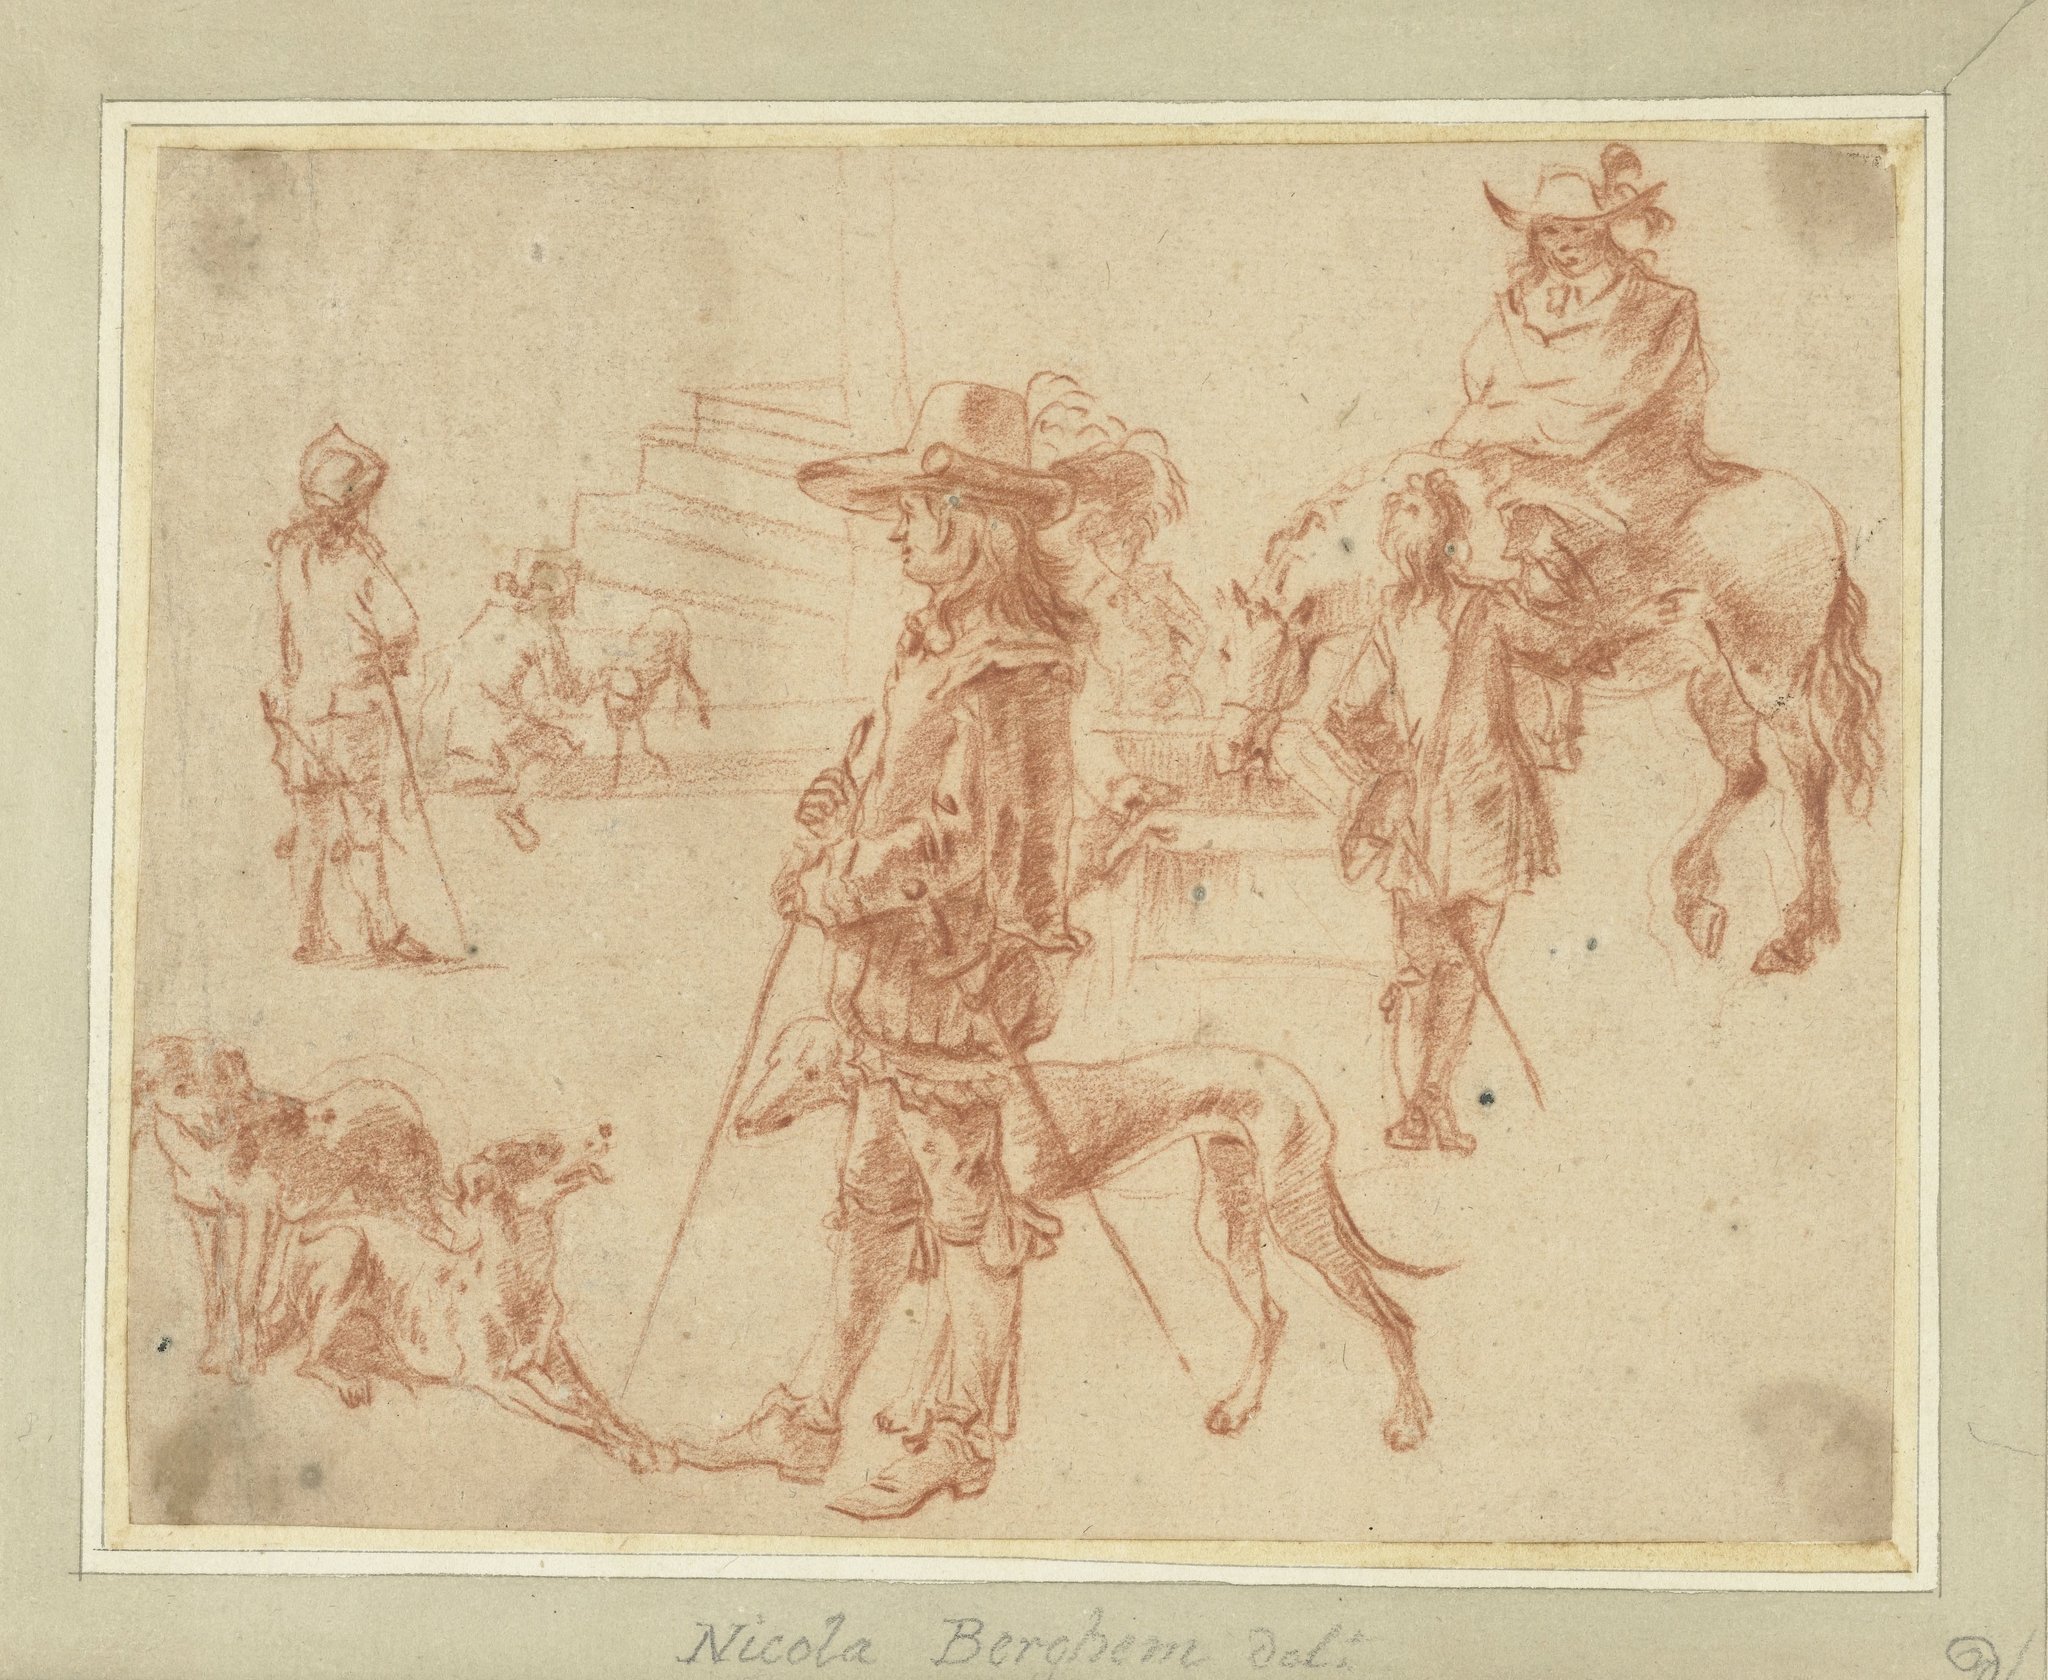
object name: drawing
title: Sheet of Studies with Hunters, Horses and Dogs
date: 1650-1654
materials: chalk, paper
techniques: drawing